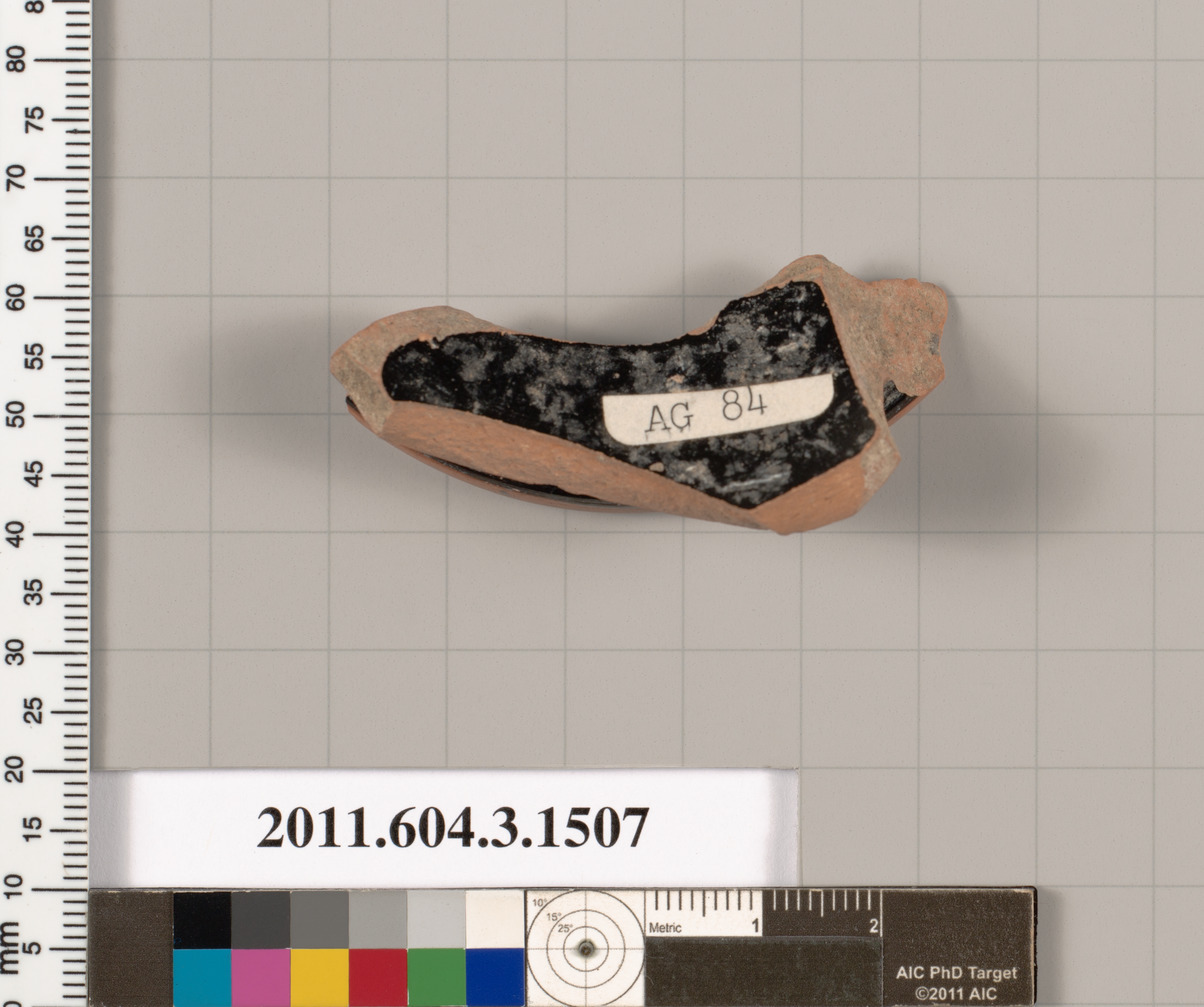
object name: skyphos fragment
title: Terracotta fragment of a skyphos (deep drinking cup)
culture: greek, attic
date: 600-401 BCE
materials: terracotta